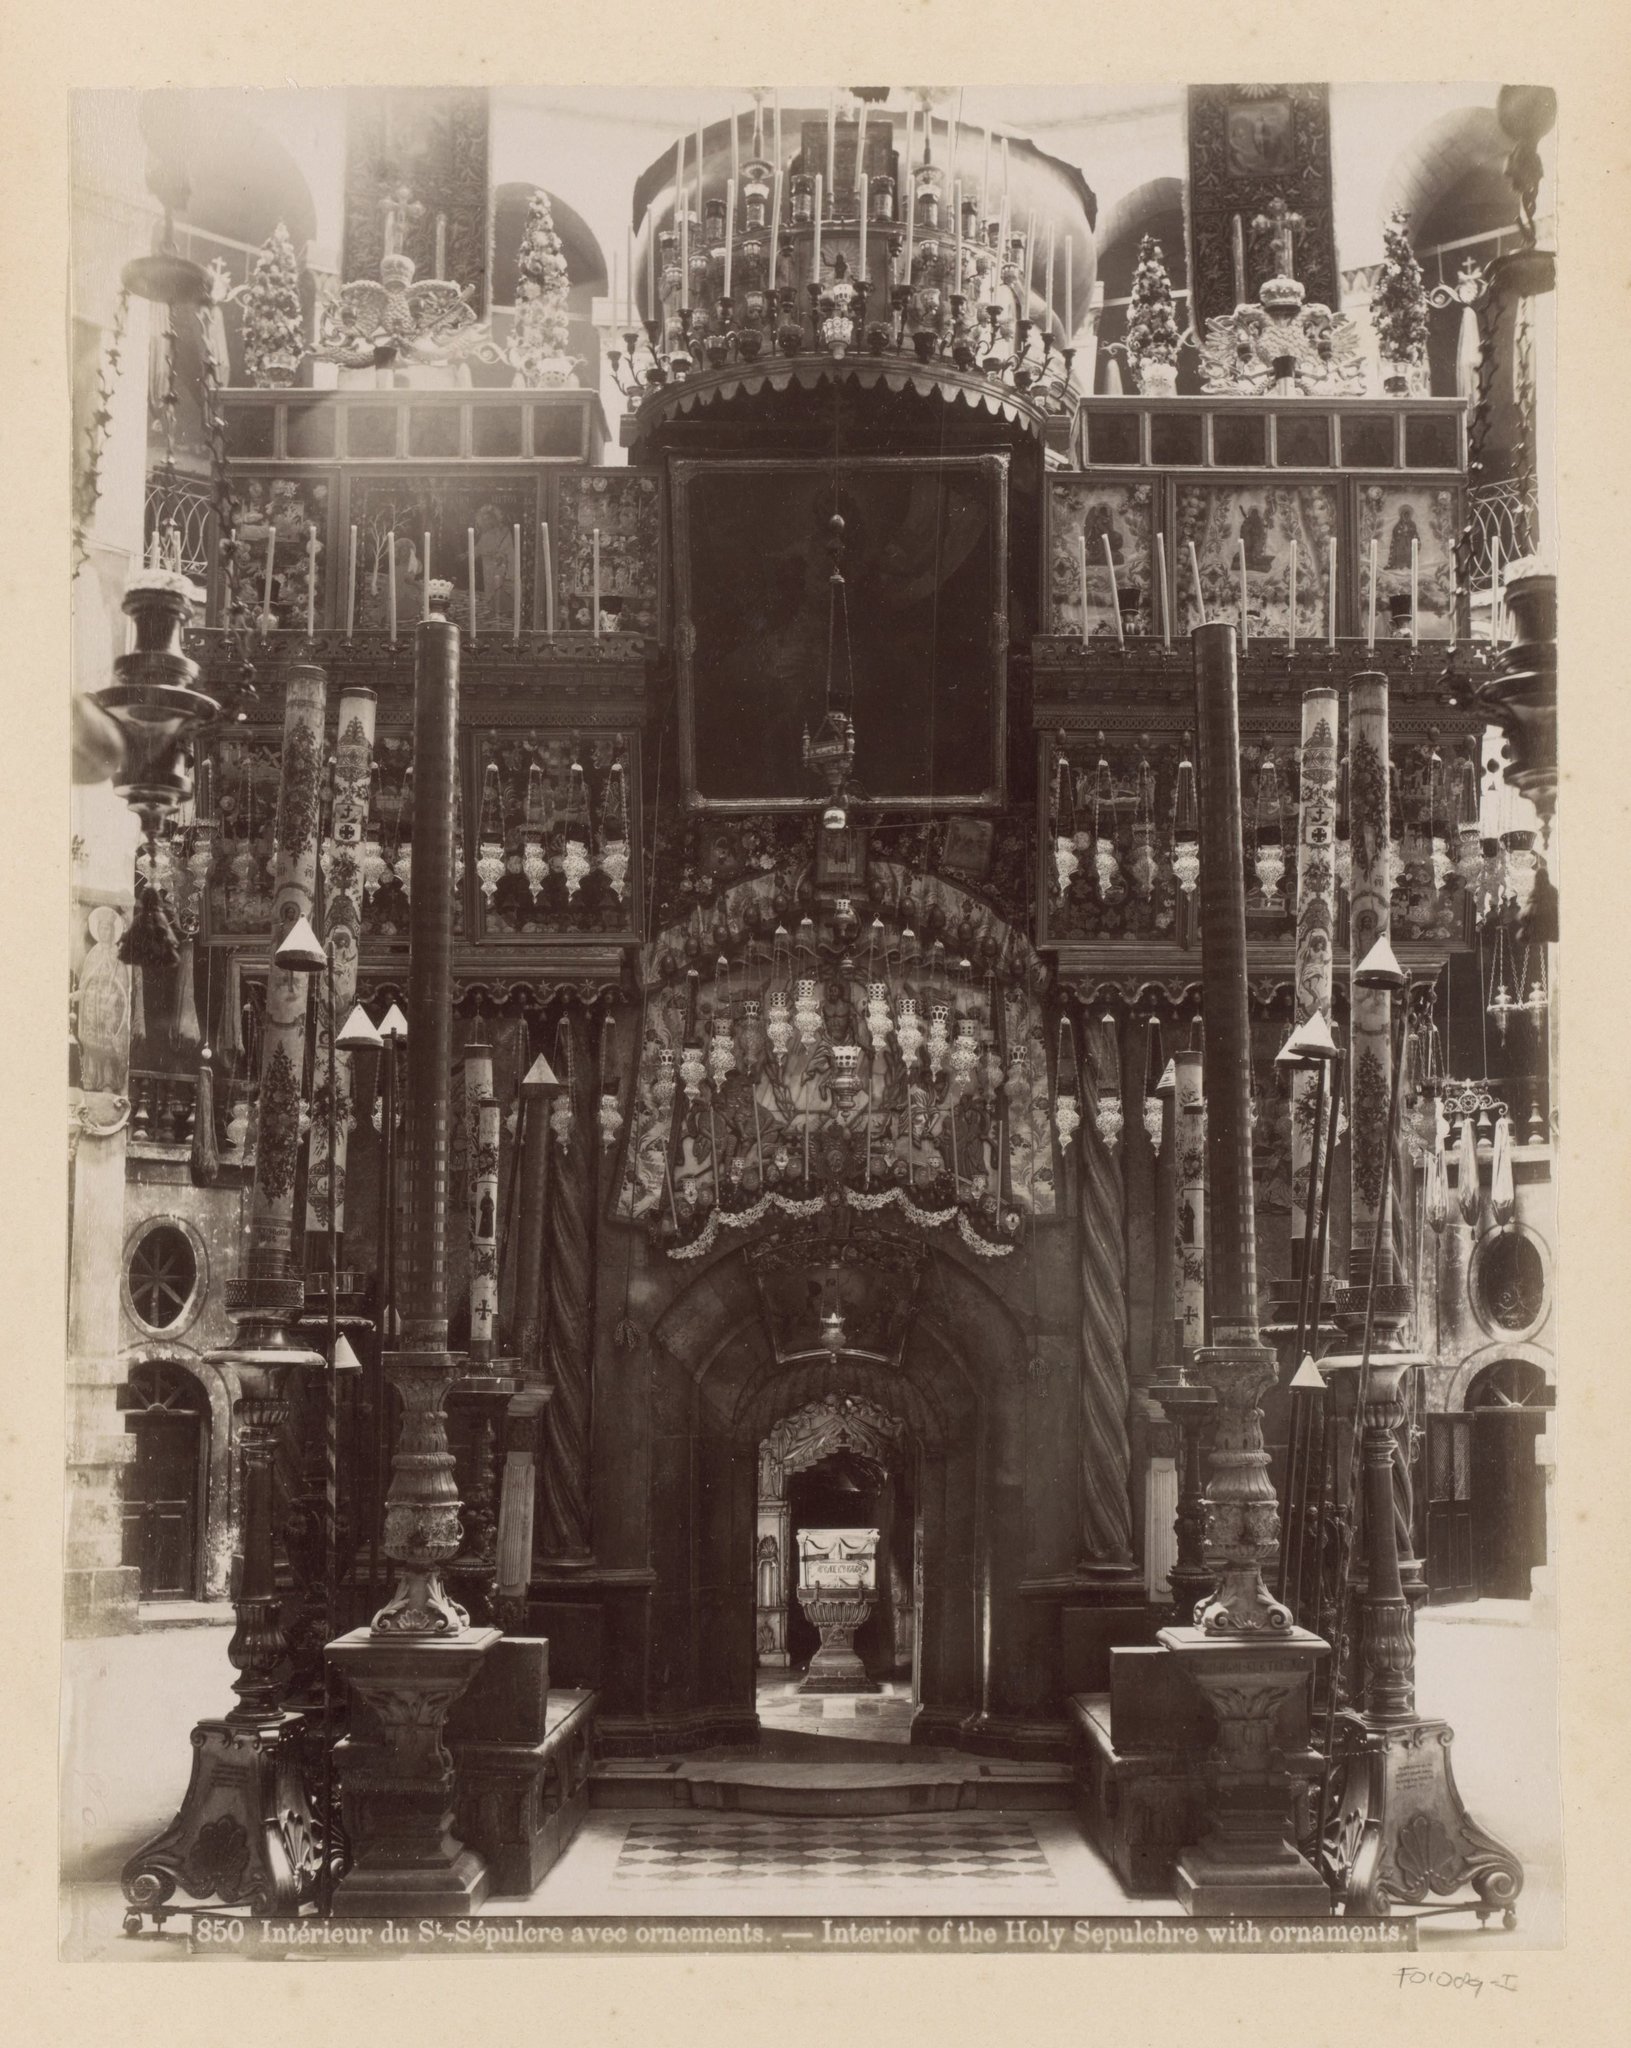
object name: photograph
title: Interieur van de Heilig-Grafkerk in Jeruzalem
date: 1867-1895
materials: cardboard, paper, photographic support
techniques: albumen print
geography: jerusalem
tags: interior of church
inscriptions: negative number: ‘850’, inscription: ‘[...]ves No. 74’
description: Onderdeel van Reisalbum met foto's van Jeruzalem en andere bijbelse plaatsen.